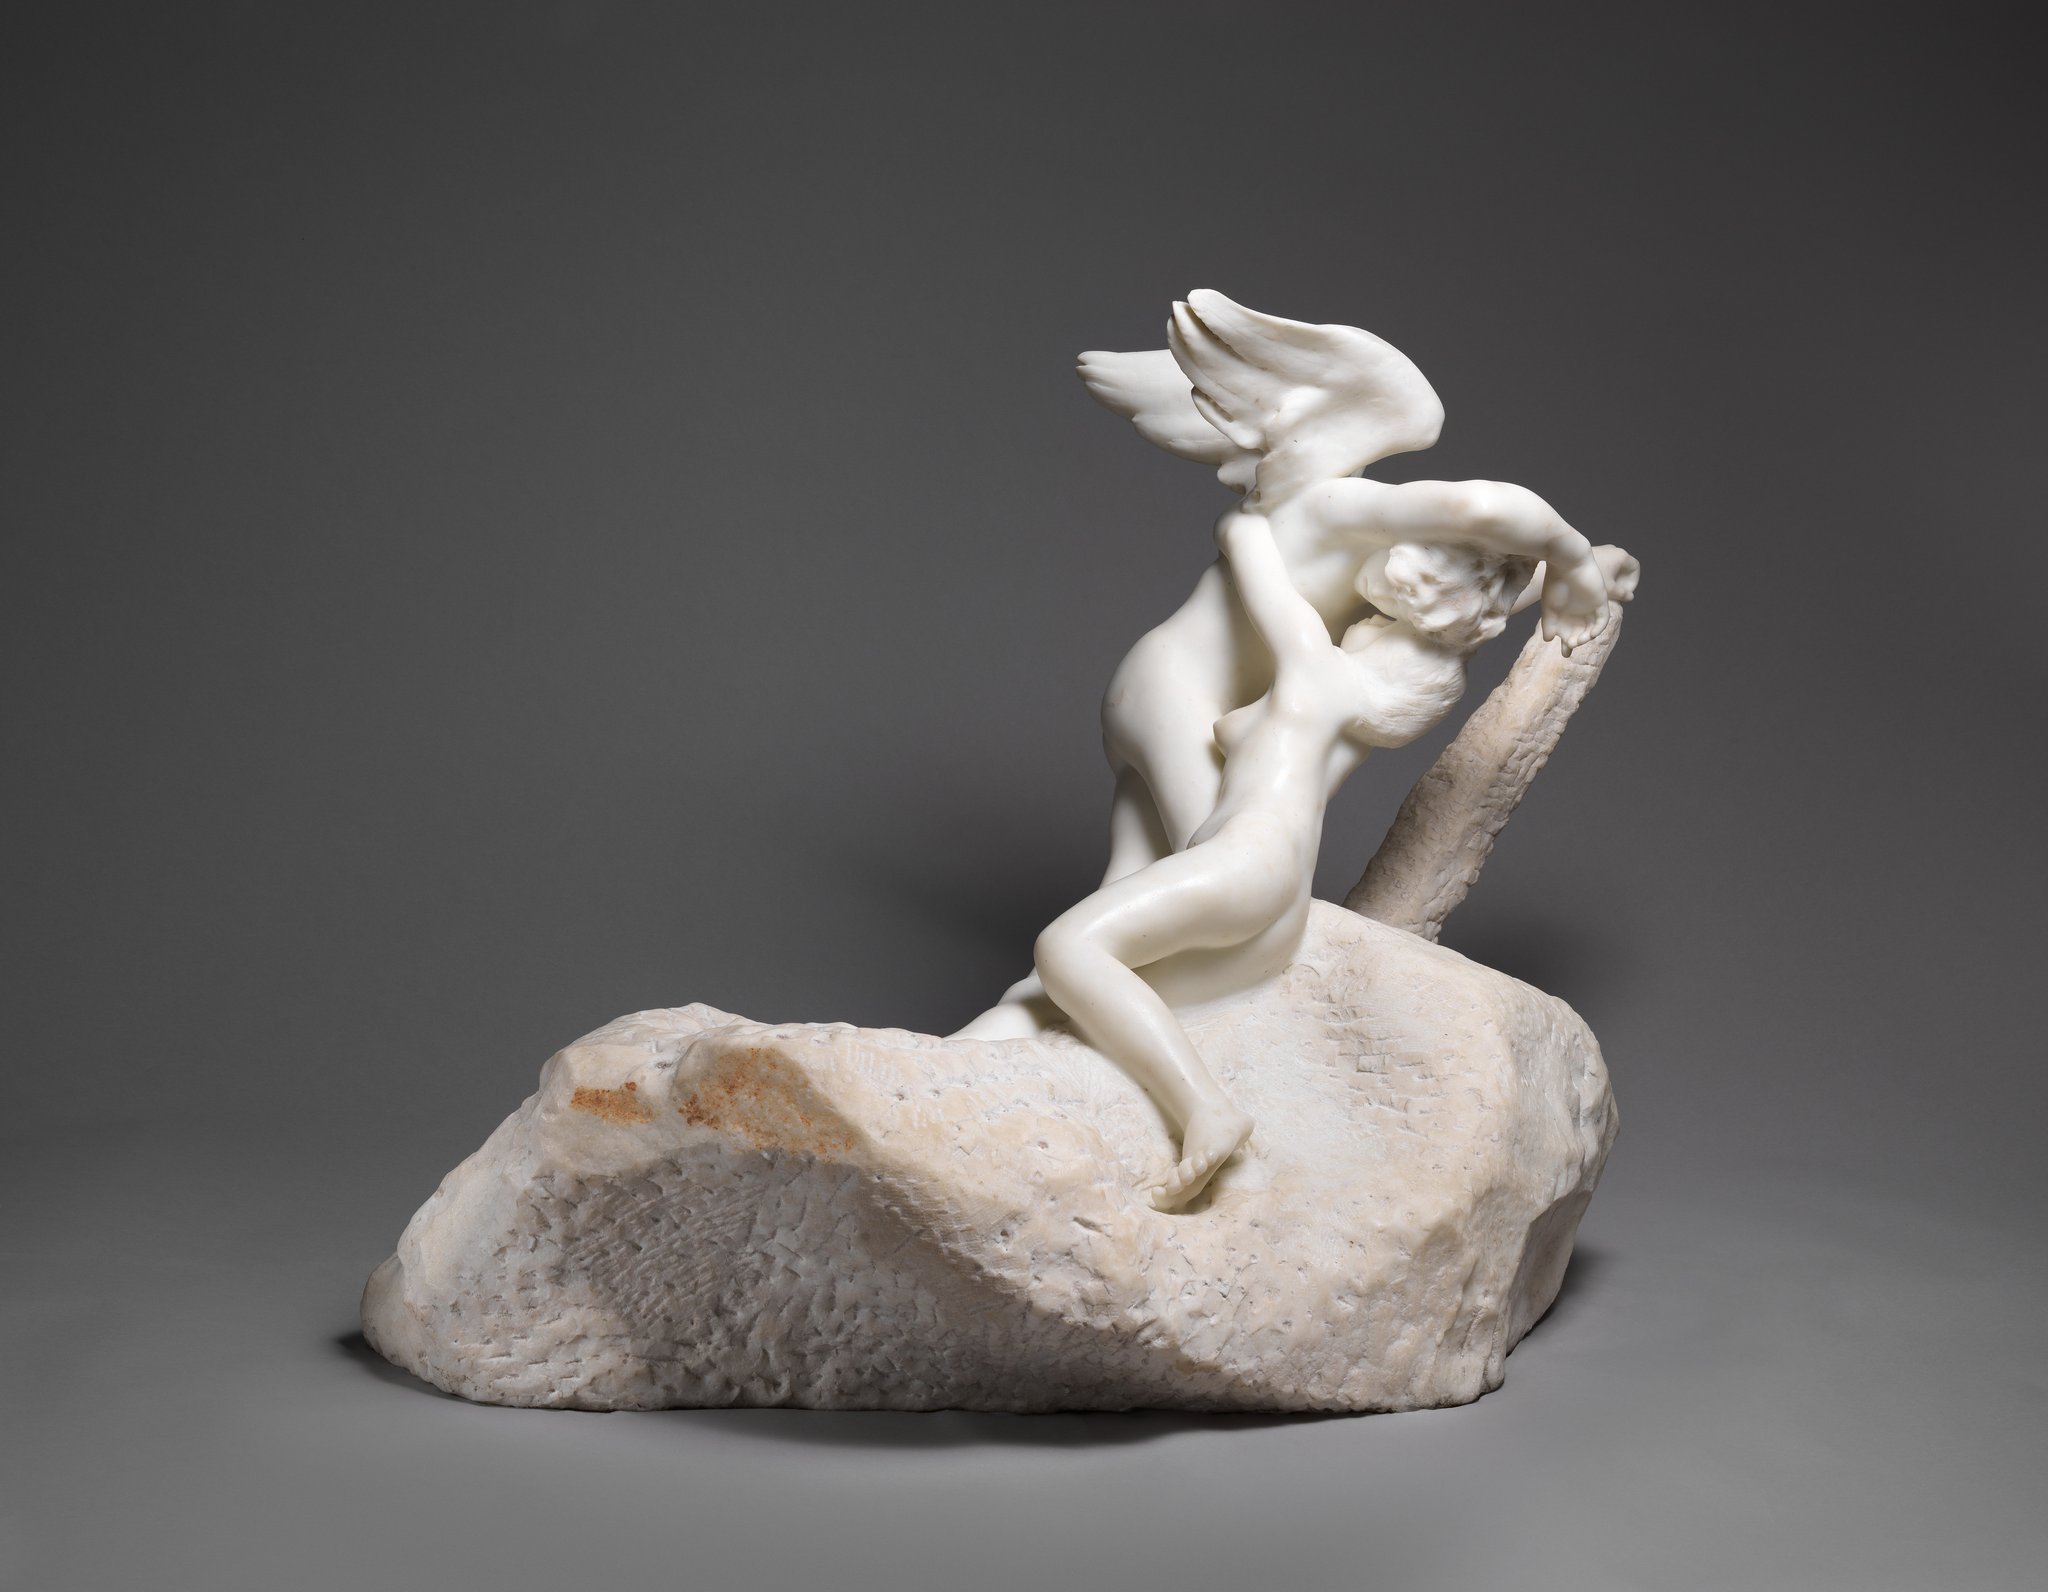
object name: group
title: Cupid and Psyche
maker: auguste rodin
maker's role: artist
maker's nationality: french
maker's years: 1840-1917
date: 1893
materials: marble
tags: female nudes,cupid,psyche